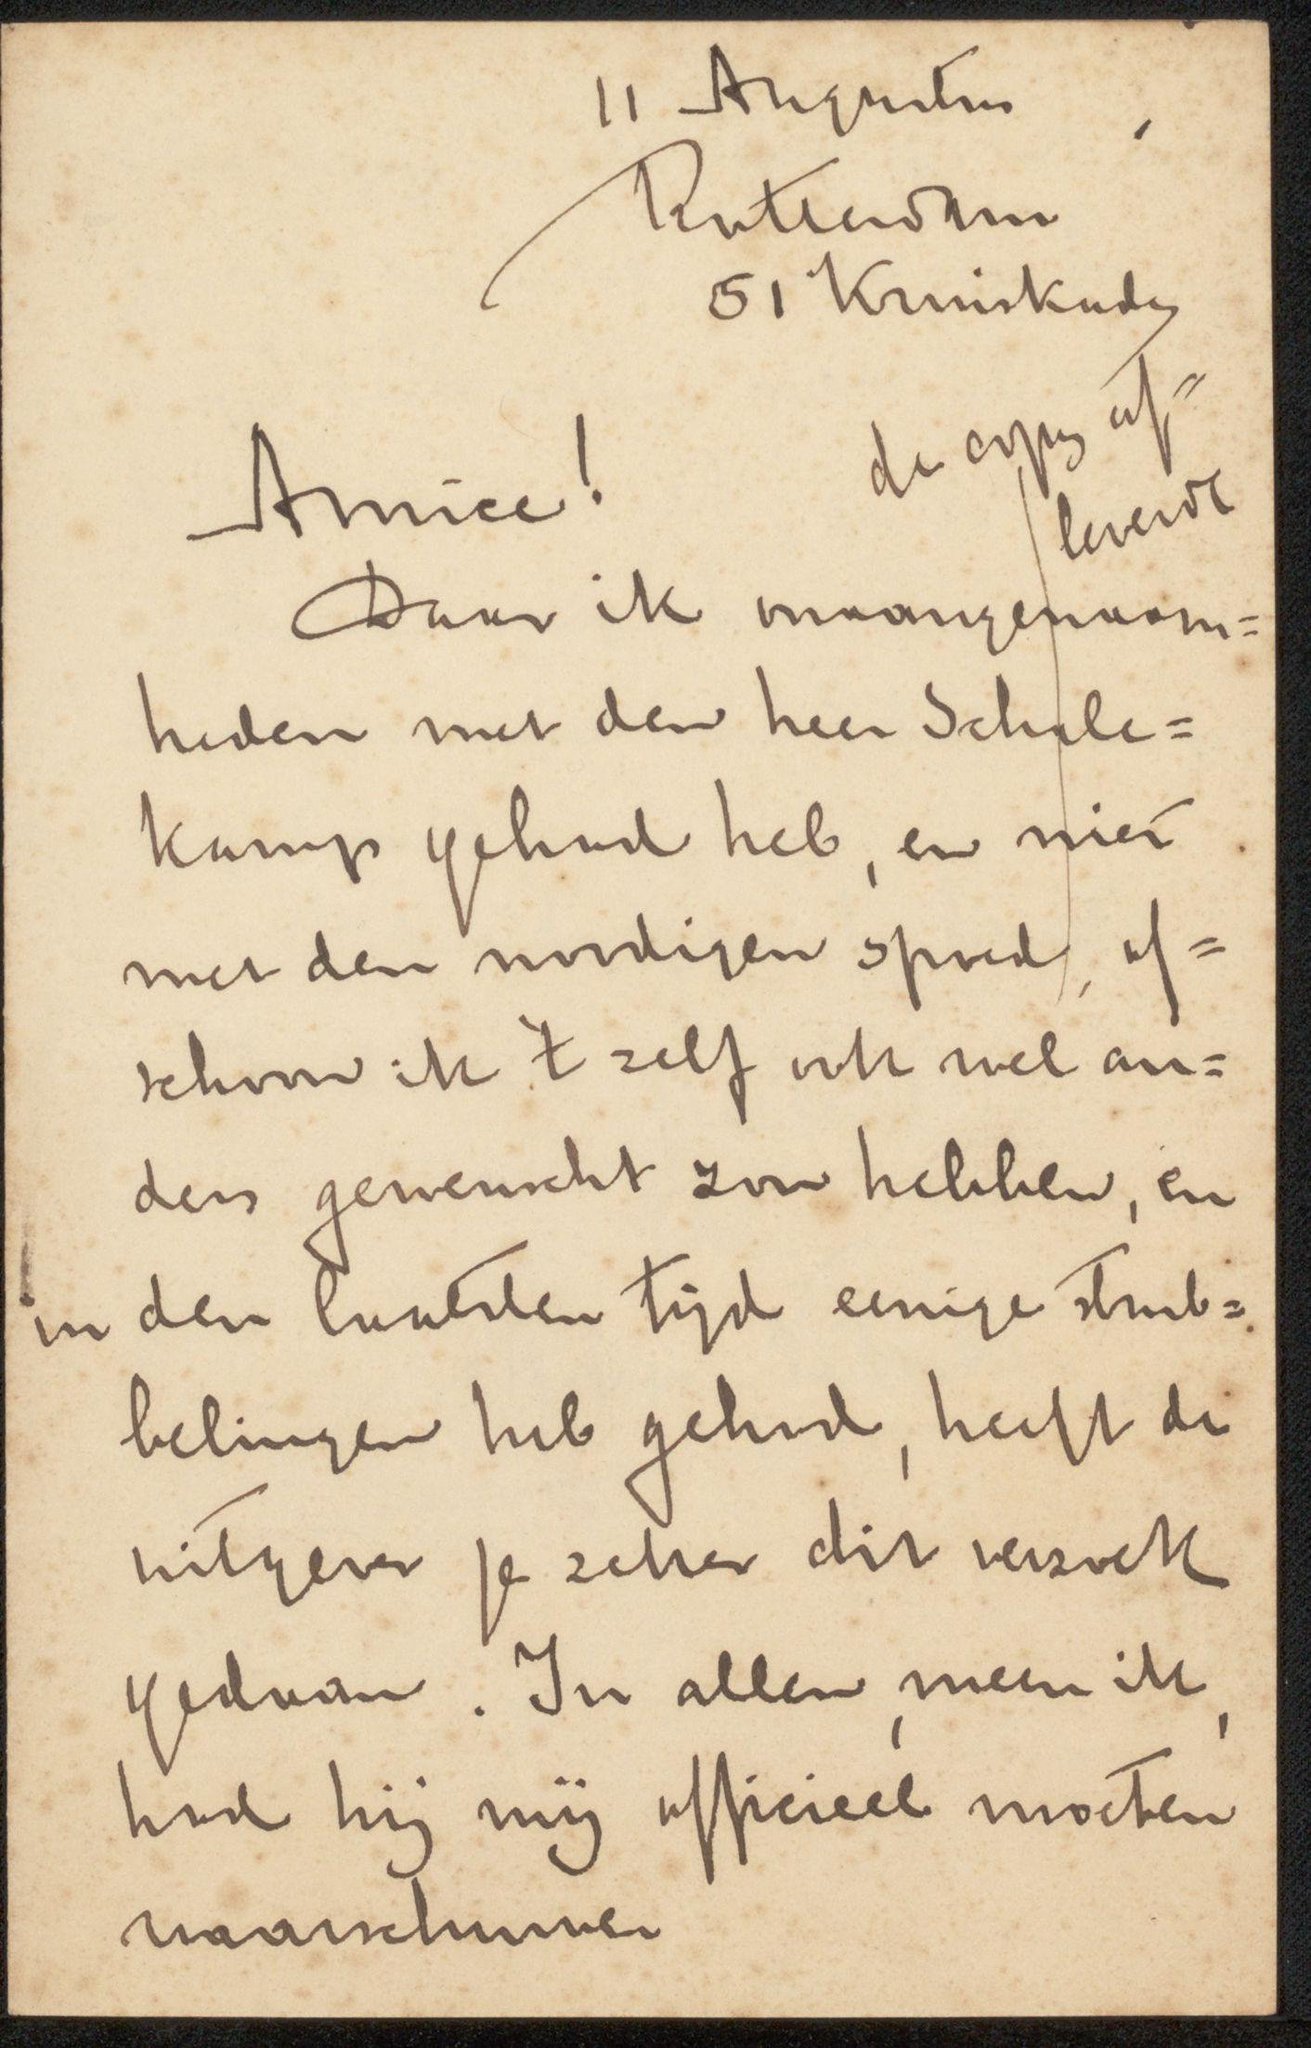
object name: letter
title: Brief aan Philip Zilcken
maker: frans netscher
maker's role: journalist, letterkundige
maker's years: 1864-1923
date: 1874-1923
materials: ink, paper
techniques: pen, writing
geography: rotterdam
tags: utrecht, publisher, johan marinus schalekamp, the hague, painter, draughtsman, philip zilcken, printed matter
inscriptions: watermark, collector's mark: ‘RPK’